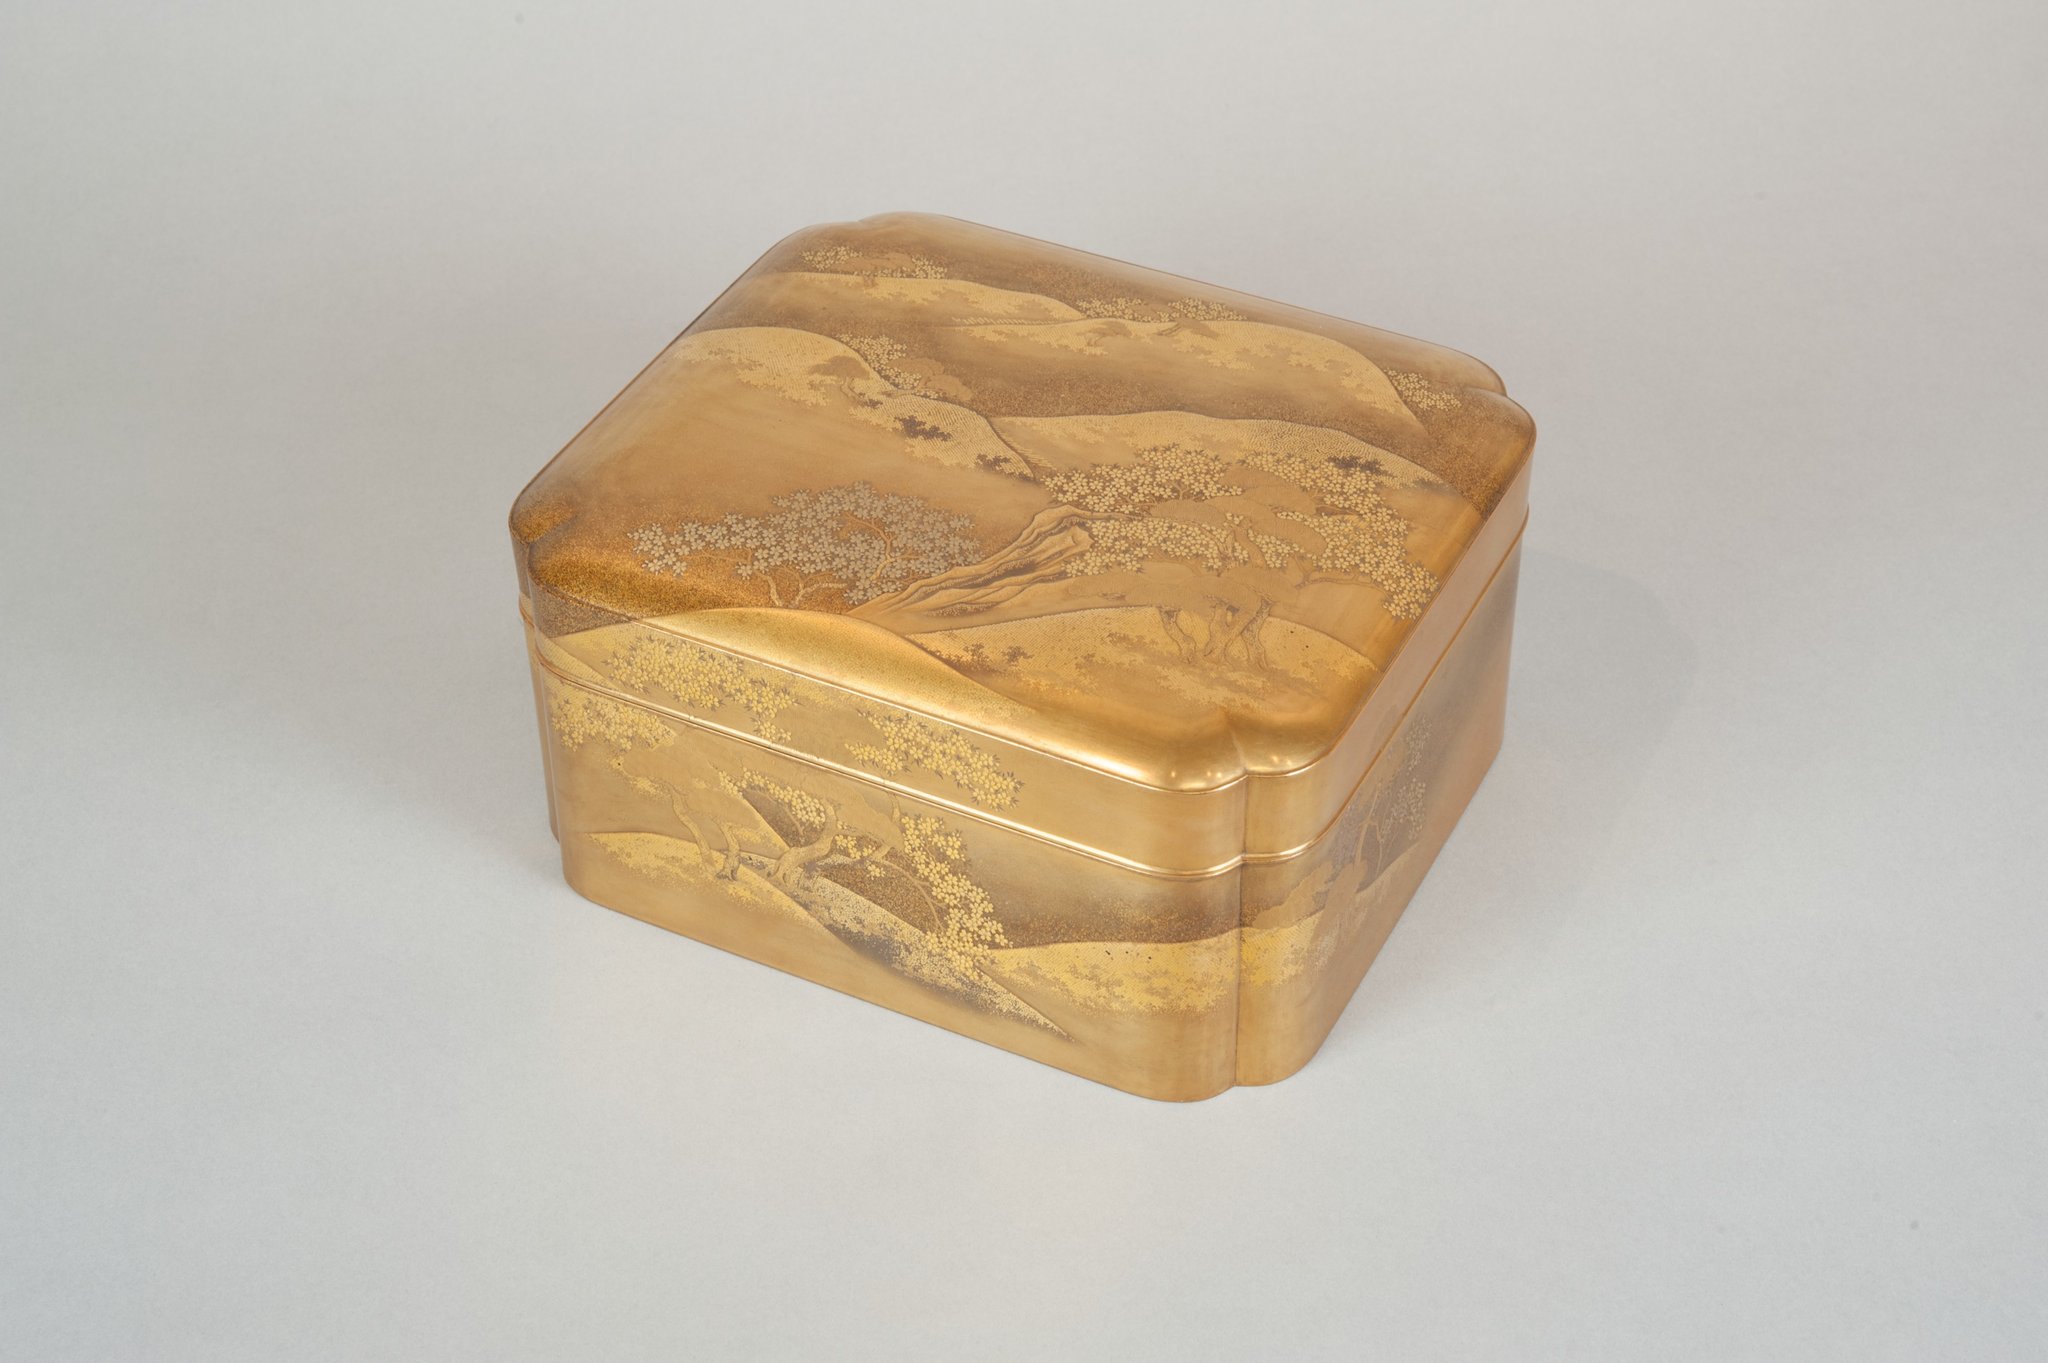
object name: box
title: Box with Design of Cherry Blossoms at Mount Yoshino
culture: japanese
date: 1801-1900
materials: gold, lacquer, silver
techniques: maki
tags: flowers,mountains,trees